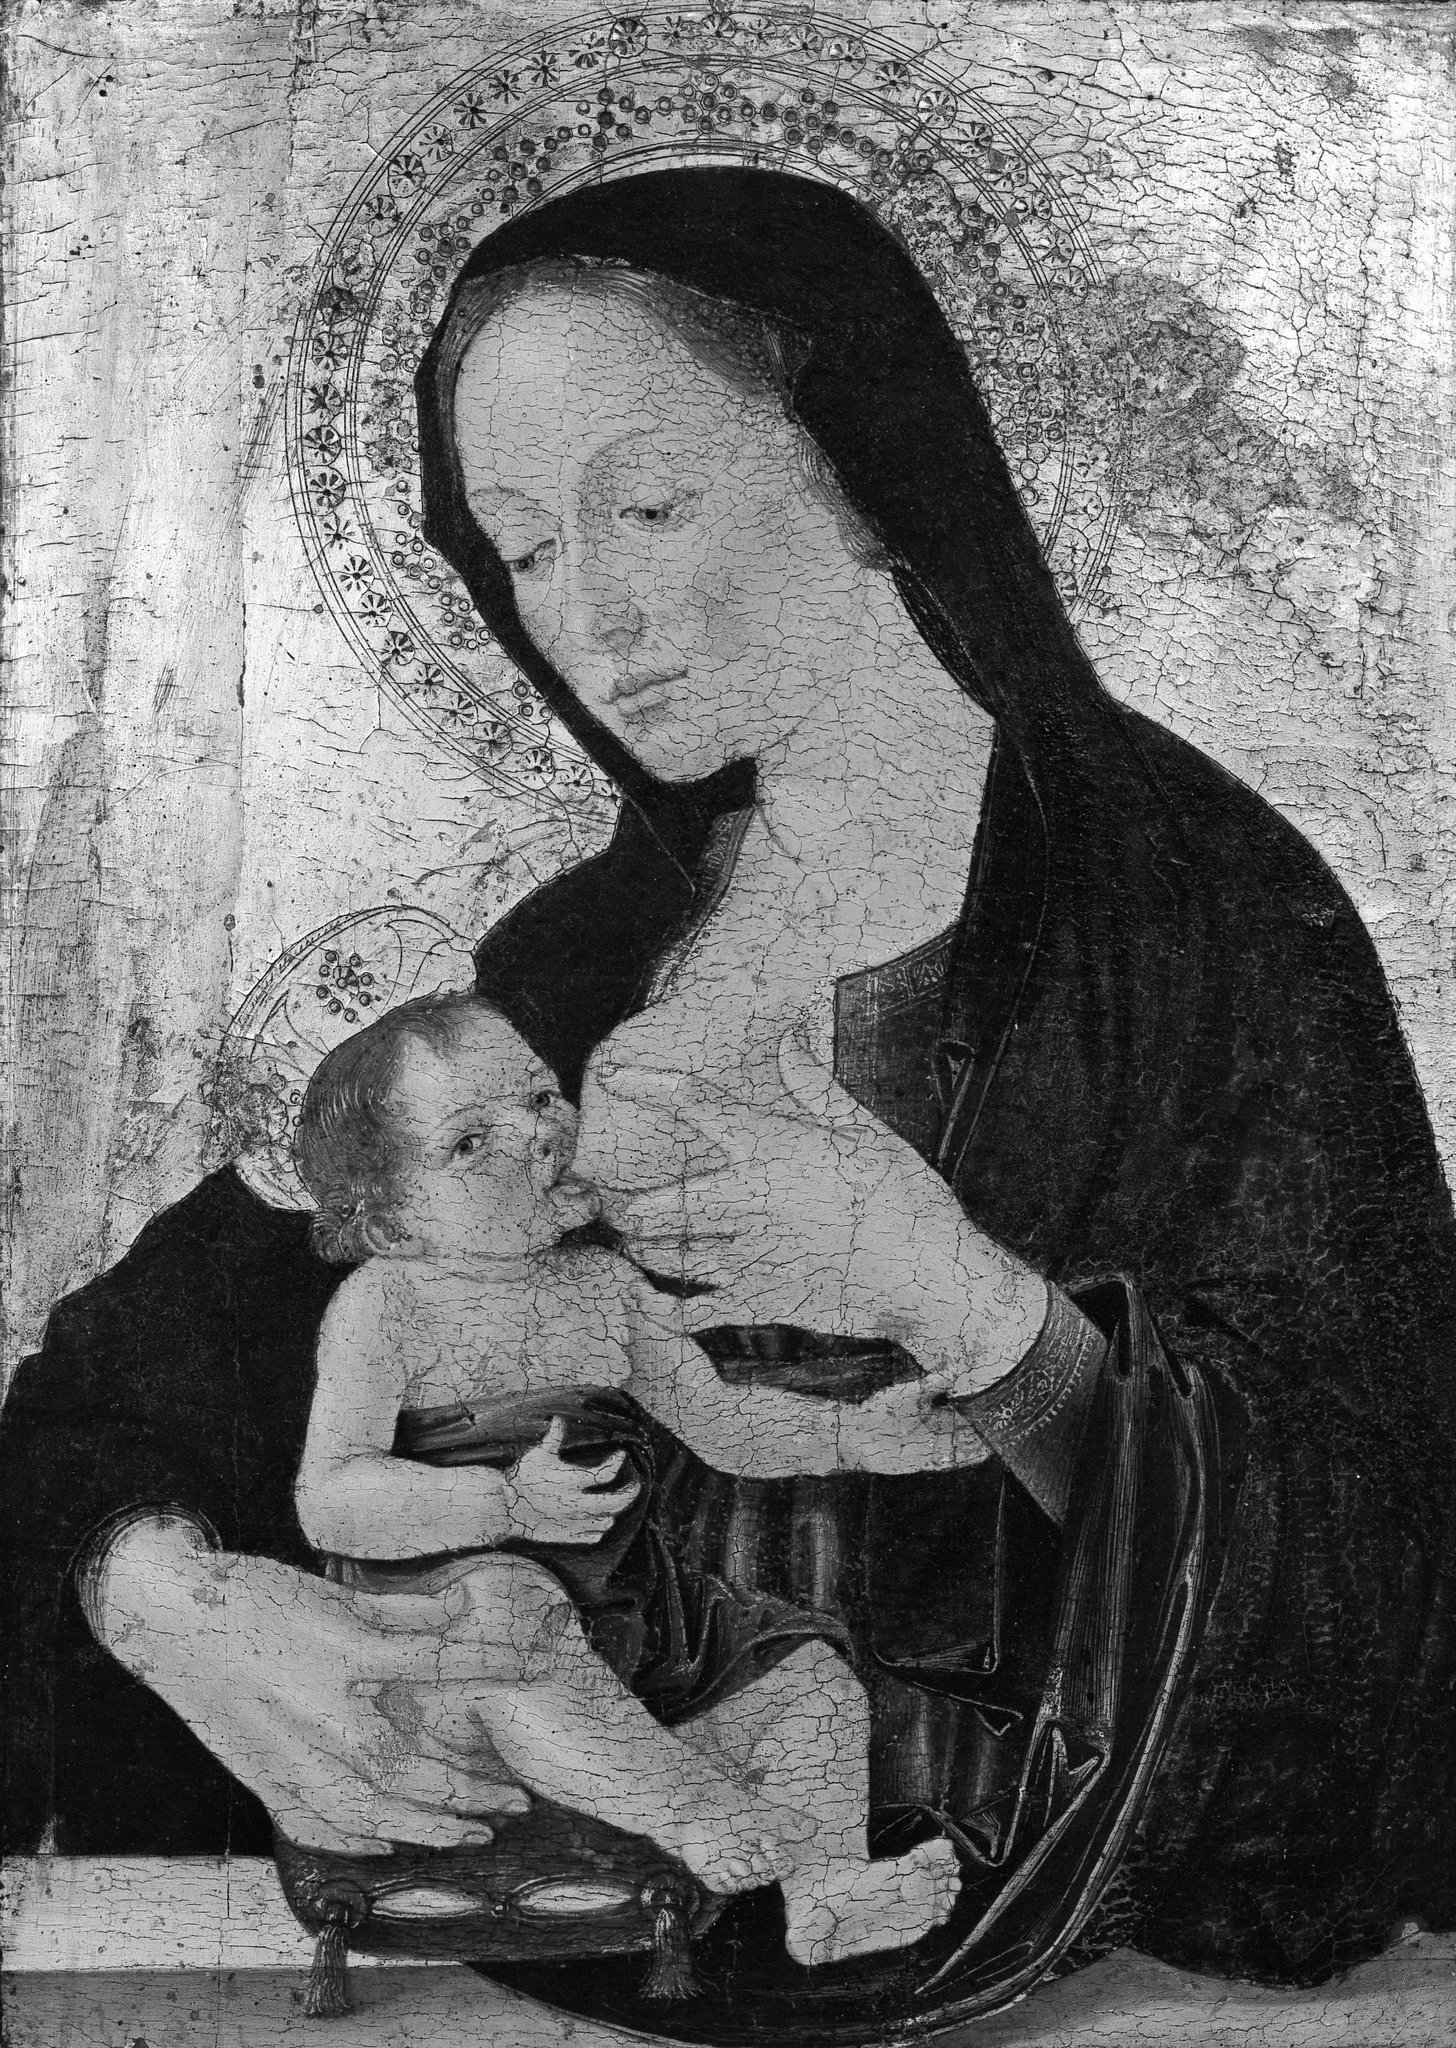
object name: painting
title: Madonna and Child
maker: antoniazzo romano (antonio di benedetto aquilio)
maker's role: artist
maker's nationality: italian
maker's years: 1435-1508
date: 1452-1512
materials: gold leaf, paint, wood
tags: madonna and child,nursing